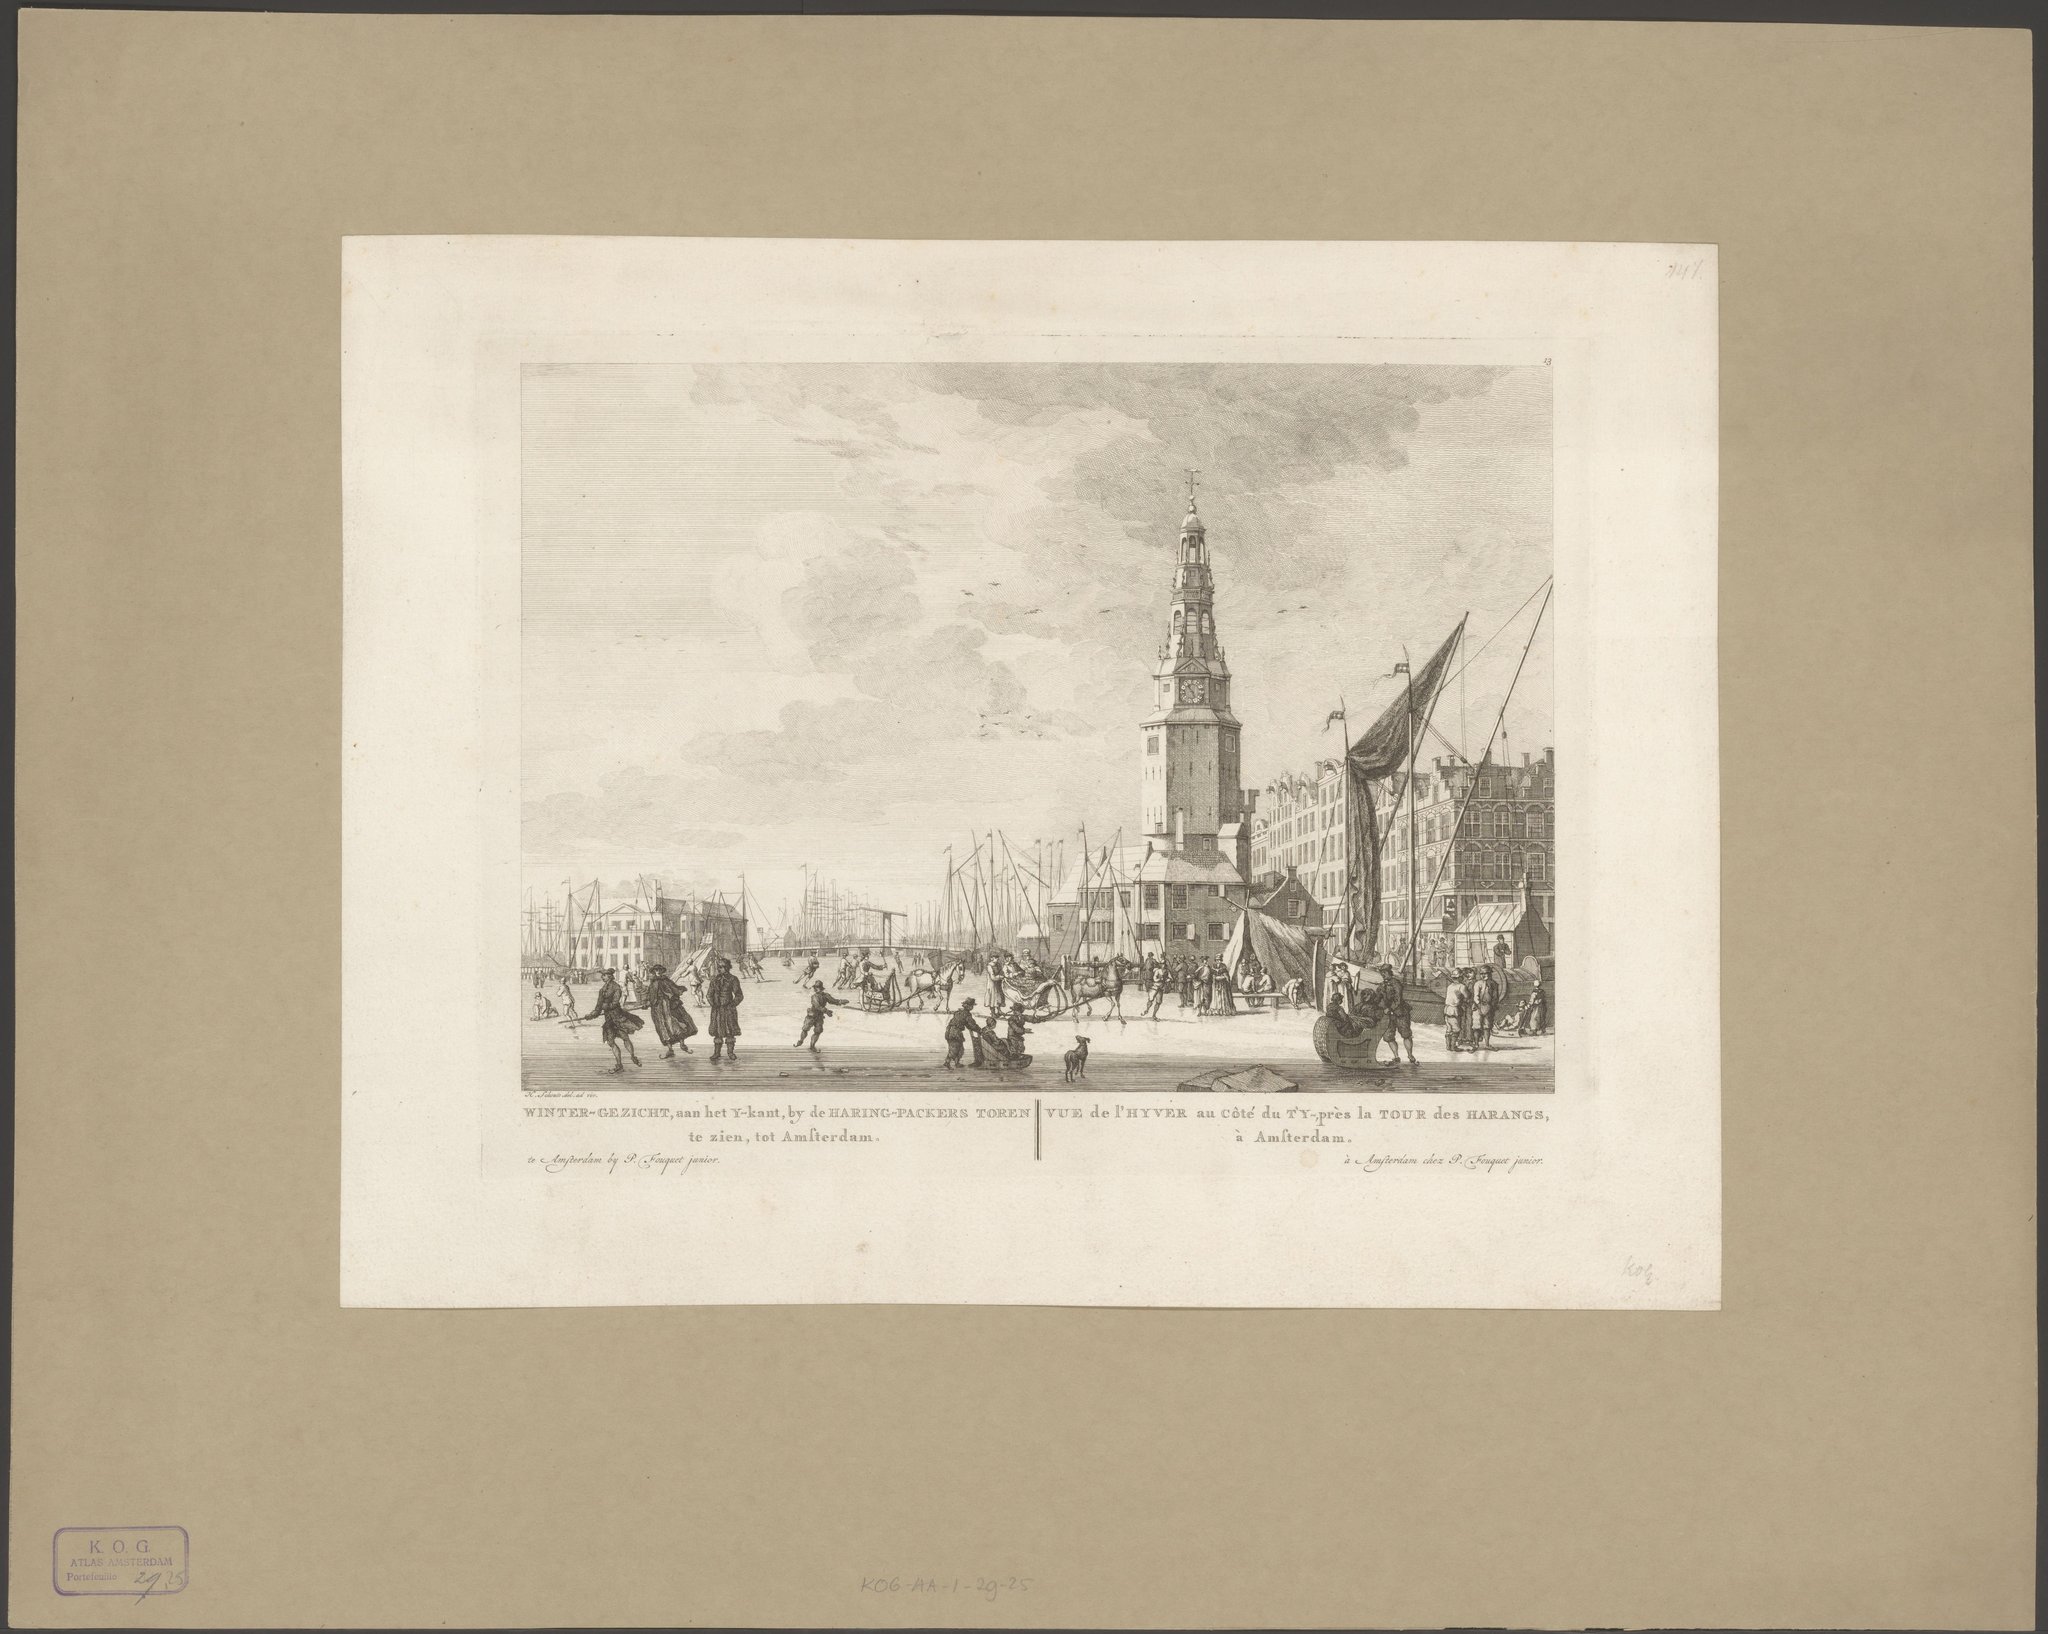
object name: print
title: Wintergezicht bij de Haringpakkerstoren te Amsterdam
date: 1770-1783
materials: paper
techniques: engraving, etching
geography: amsterdam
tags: tower, clock tower ~ monumental adornment, horse-sleigh, winter ~ human activities (the four seasons of the year), skates (winter sports), sledge, sleigh (winter sports)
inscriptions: collector's mark: Lugt 1641b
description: Vanaf 1760 gaf Pierre Fouquet stadsgezichten van Amsterdam naar tekeningen van verschillende kunstenaars uit. Deze prenten werden aanvankelijk los verkocht. Later werden ze samengebonden verkocht in verschillende volgordes en aantallen in: (1). Afbeeldingen van de wyd-vermaarde koopstad Amsterdam benevens des zelvs voornaamste gebouwen en gezigten alle naar het leeven getekend / Receuil des edifices les plus considerables et des plus belles vues, de la fameuse ville d'Amsterdam, dessinées d'après nature. Amsterdam: Pierre Fouquet, 1778-1783. Deze 'uitgave' bestond waarschijnlijk alleen uit een titelblad en inhoudsopgave van de tot dusver 100 uitgegeven prenten, die de koper zelf aan zijn of haar reeds verzamelde prenten kon toevoegen. De hoeveelheid en volgorde van prenten verzameld onder deze titel verschilt dus sterk. (2). Nieuwe atlas, van de voornaamste gebouwen en gezigten der stad Amsterdam, met derzelver beknopte beschryvingen. 2 dln. Amsterdam: Daniël Jean Changuion en Petrus den Hengst [in opdracht van Pierre Fouquet], 1783. Ook werden er door verschillende uitgevers tussen 1788 (Amsterdam: Petrus Conradi) en 1805 (Amsterdam: Evert Maaskamp) heruitgaven gepubliceerd.